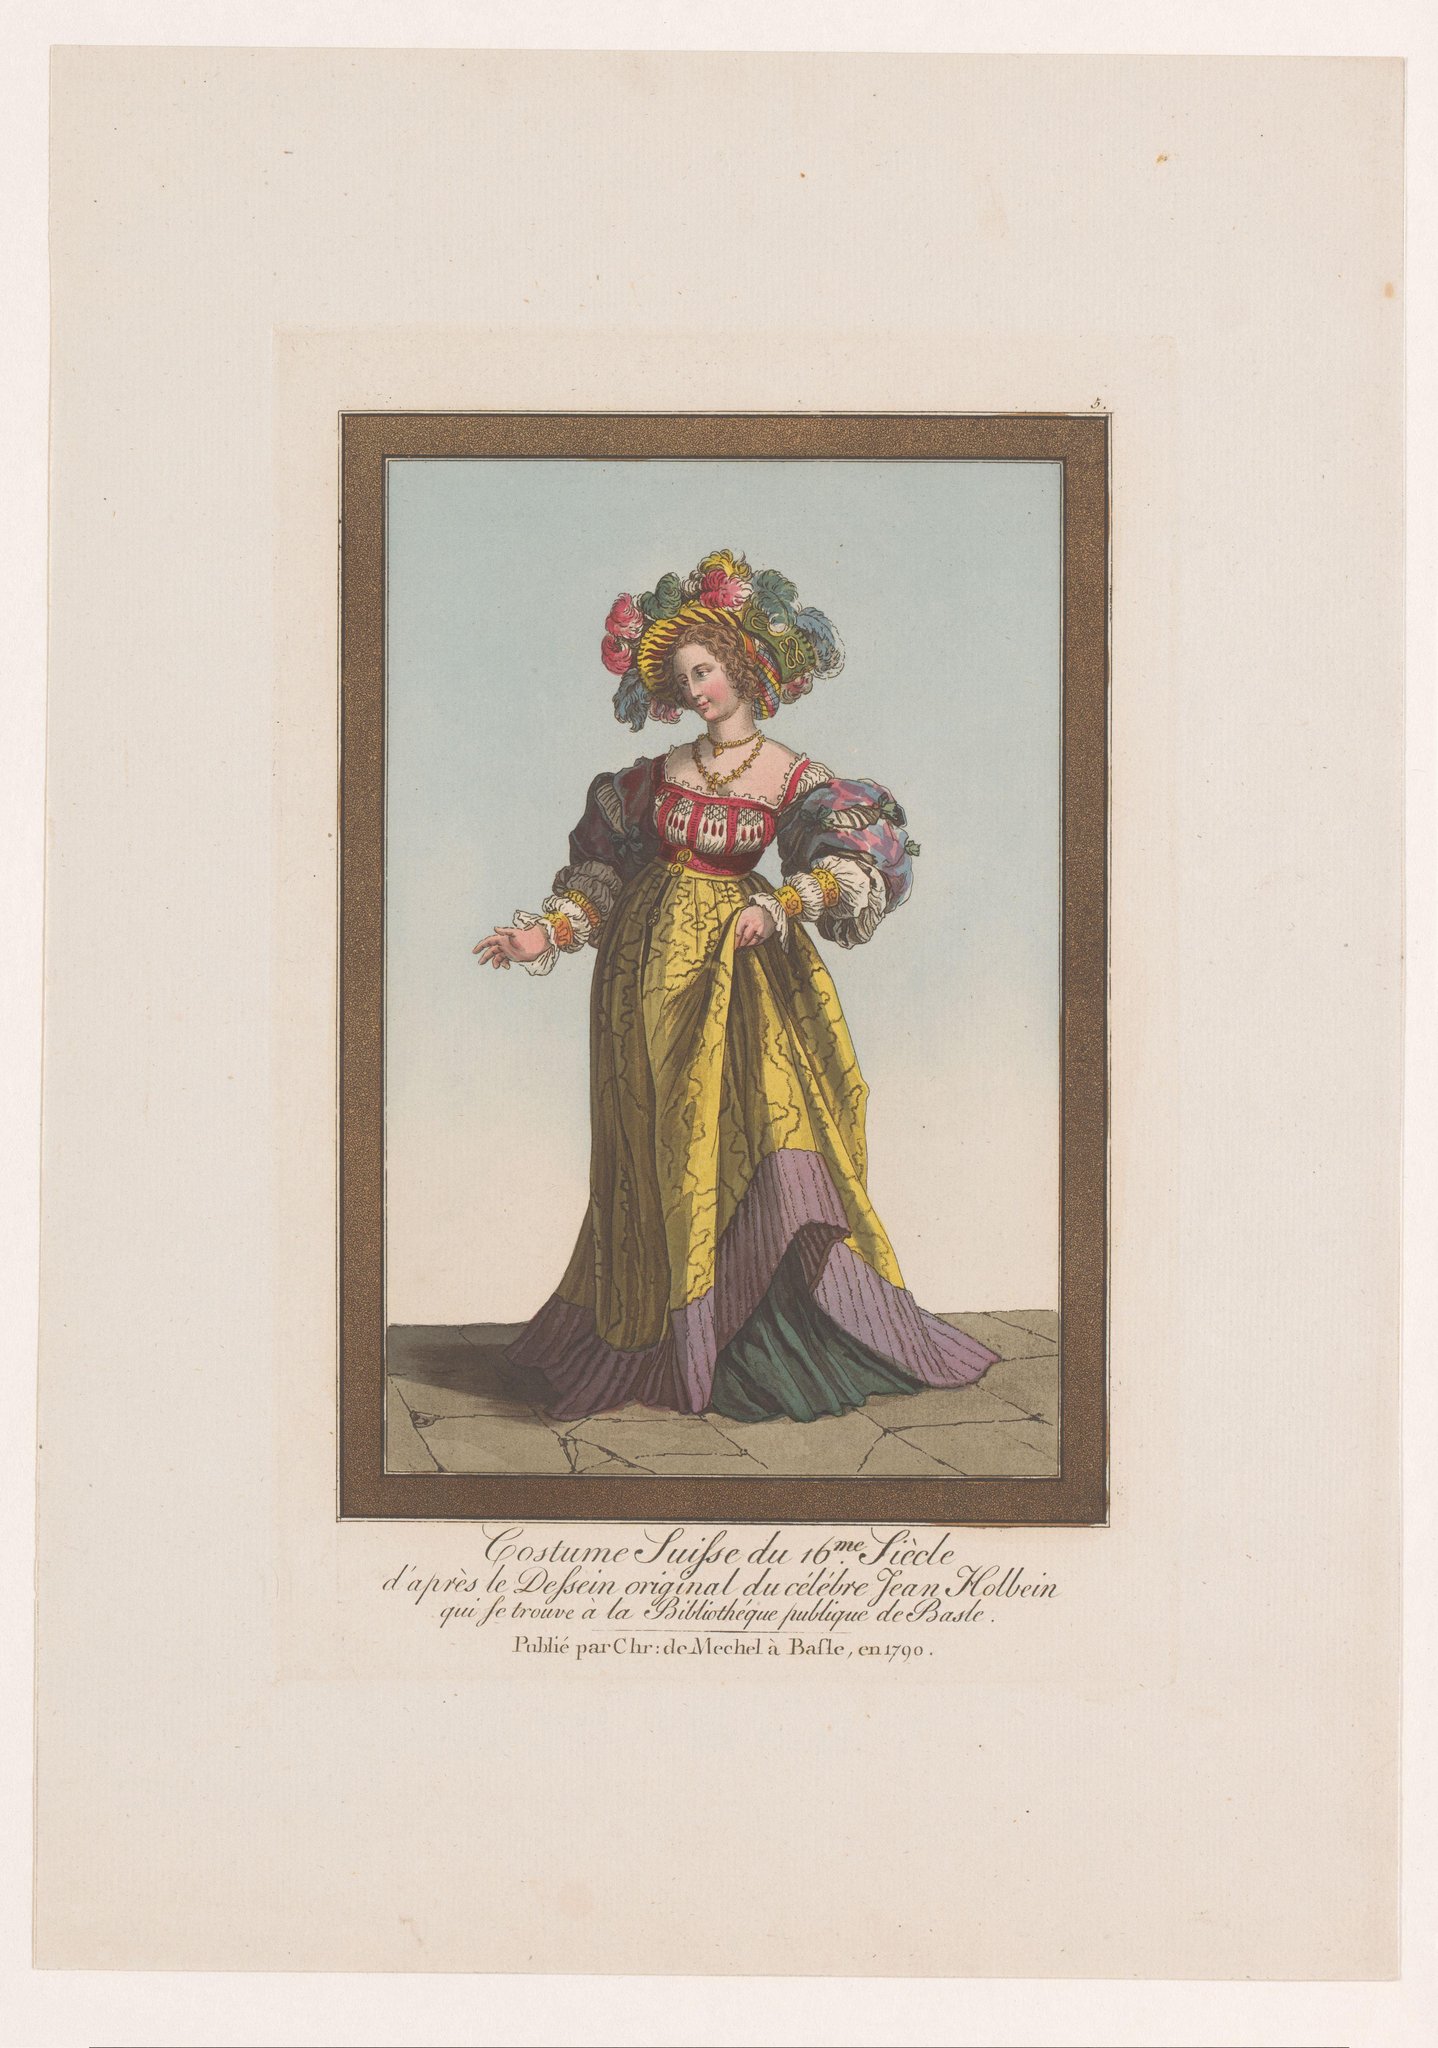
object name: print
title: Recueil de XII costumes Suisses civils et militaires, hommes et femmes, du seizième siècle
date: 1790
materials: paper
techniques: aquatint, etching, hand coloring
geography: basel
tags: dress, gown: court gown or court dress, clothes, costume, switzerland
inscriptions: collector's mark: Lugt 2228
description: De serie behoort tot de 4-delige publicatie 'Oeuvre de Jean Holbein', Bazel 1780-1795, door Christian von Mechel.